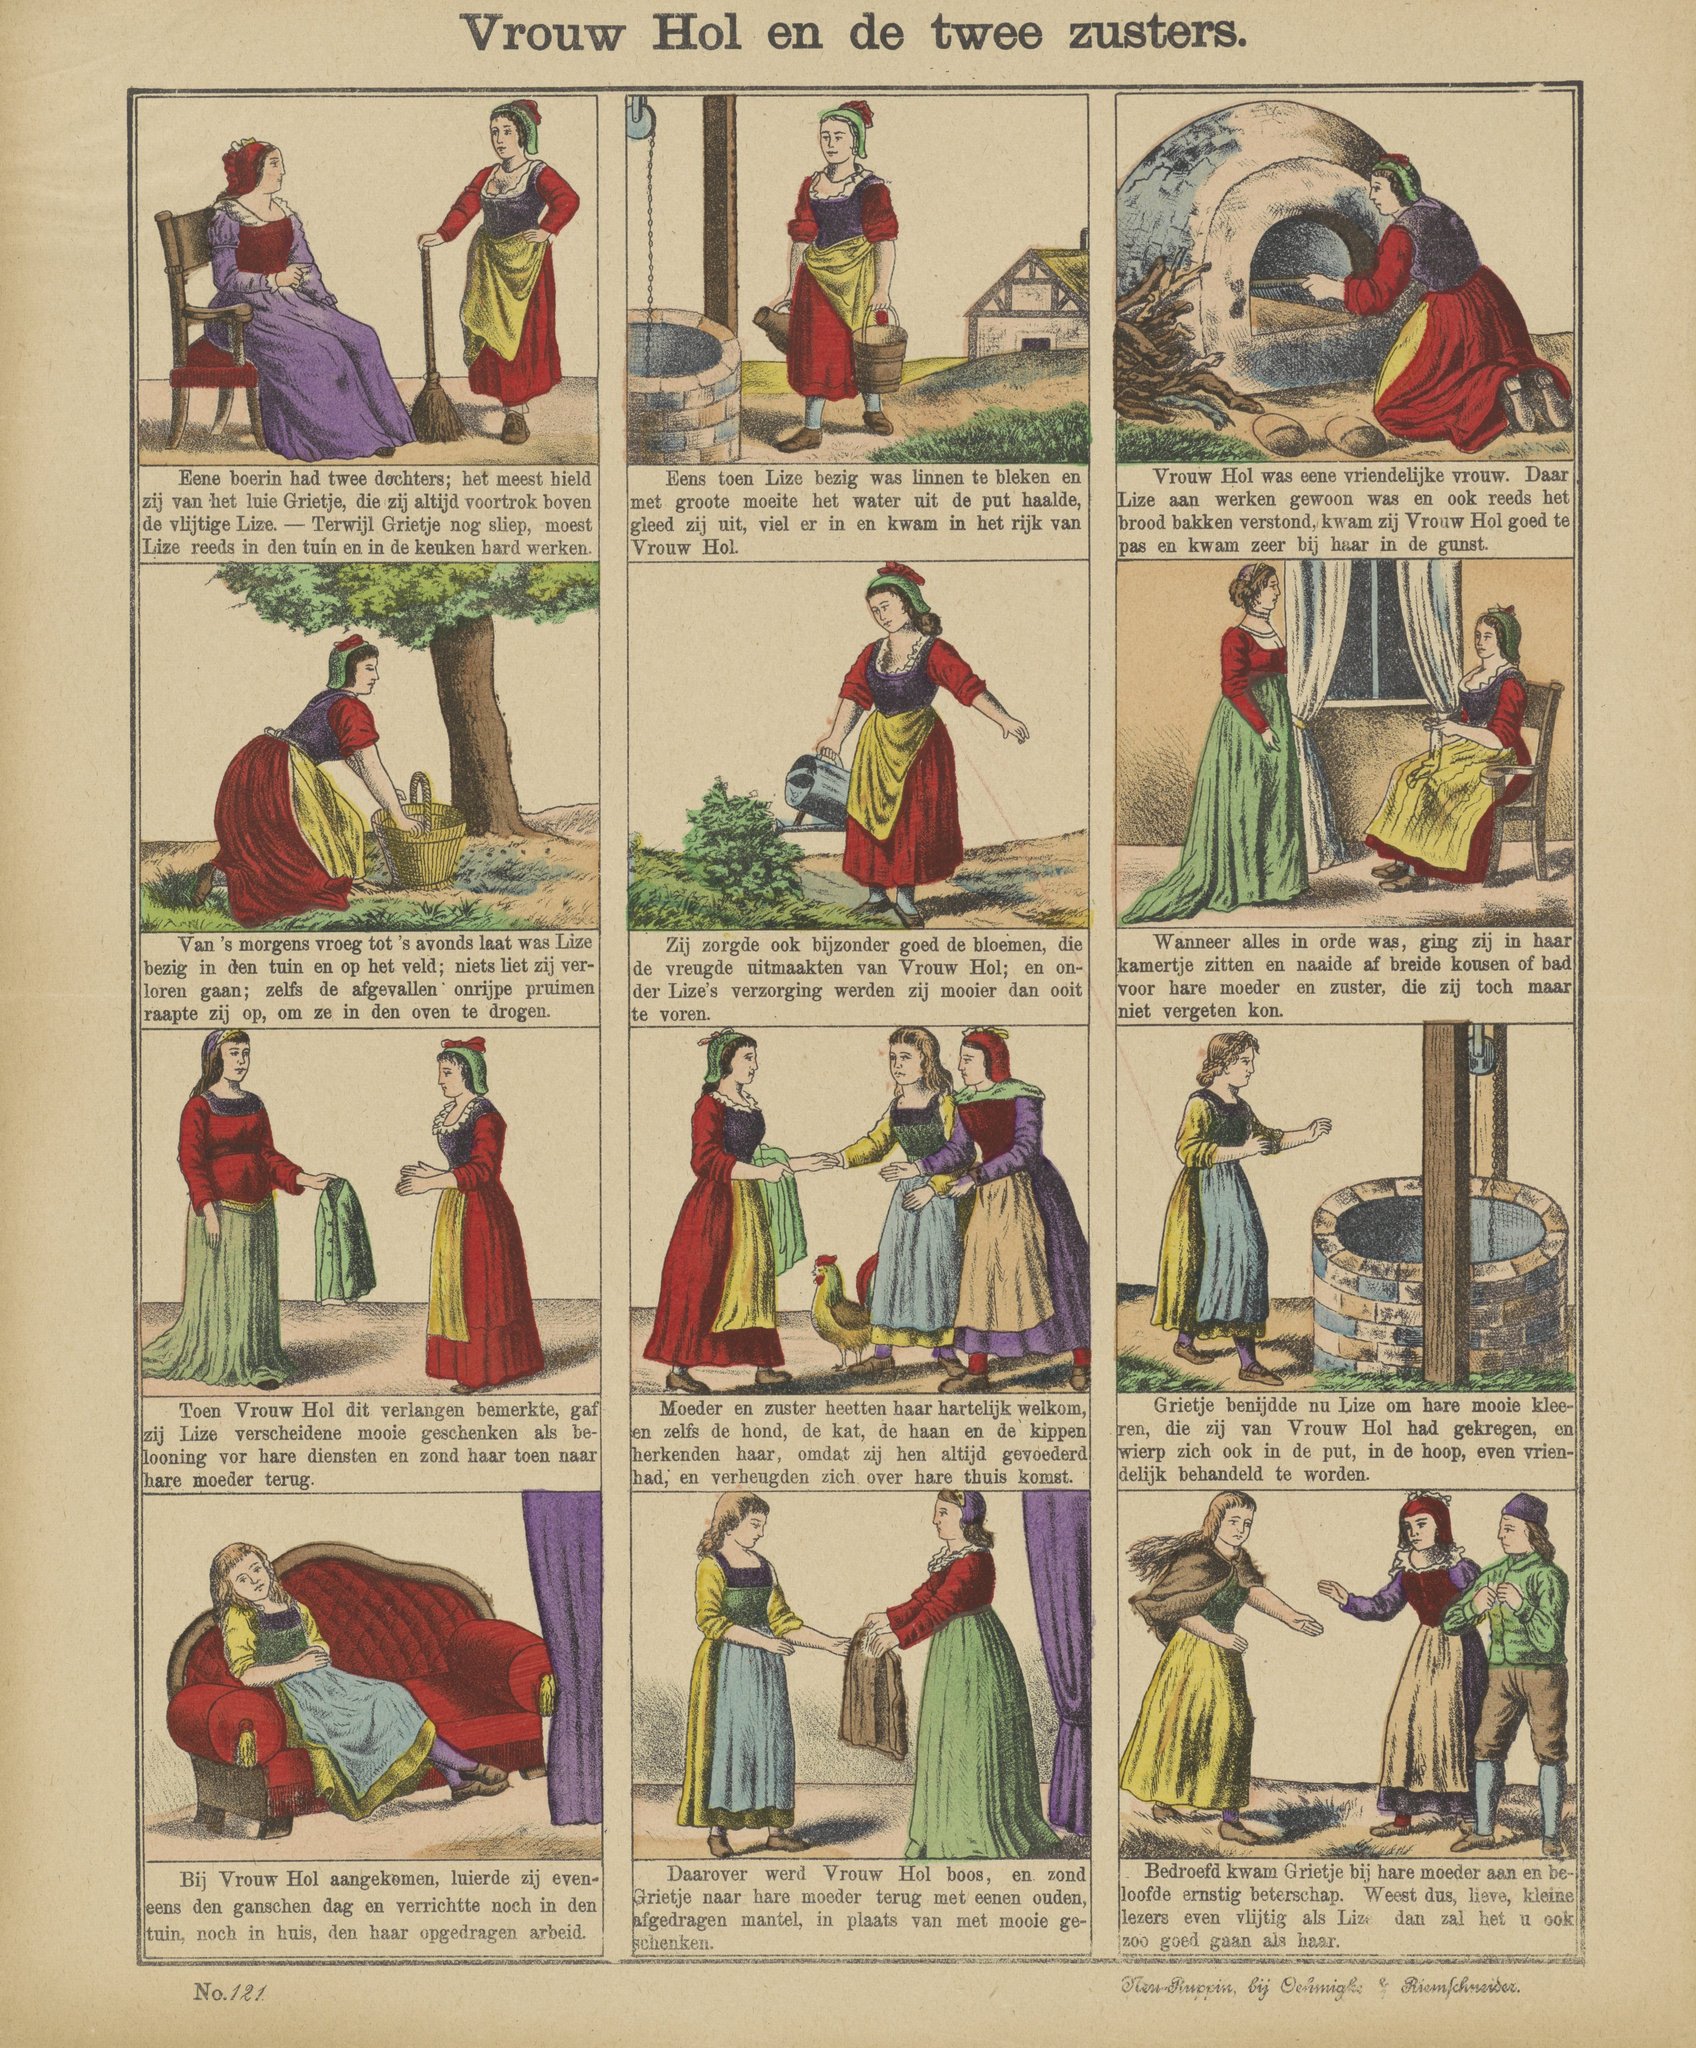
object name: popular print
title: Vrouw Hol en de twee zusters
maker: Anonymous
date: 1828-1937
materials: paper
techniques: hand coloring, letterpress printing, lithograph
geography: neuruppin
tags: tales and fairy tales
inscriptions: collector's mark: Lugt 2760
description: Blad met 16 voorstellingen uit het sprookje van Vrouw Holle en de twee zusters Grietje en Liesje. Onder elke afbeelding een onderschrift. Genummerd linksonder: No. 121.